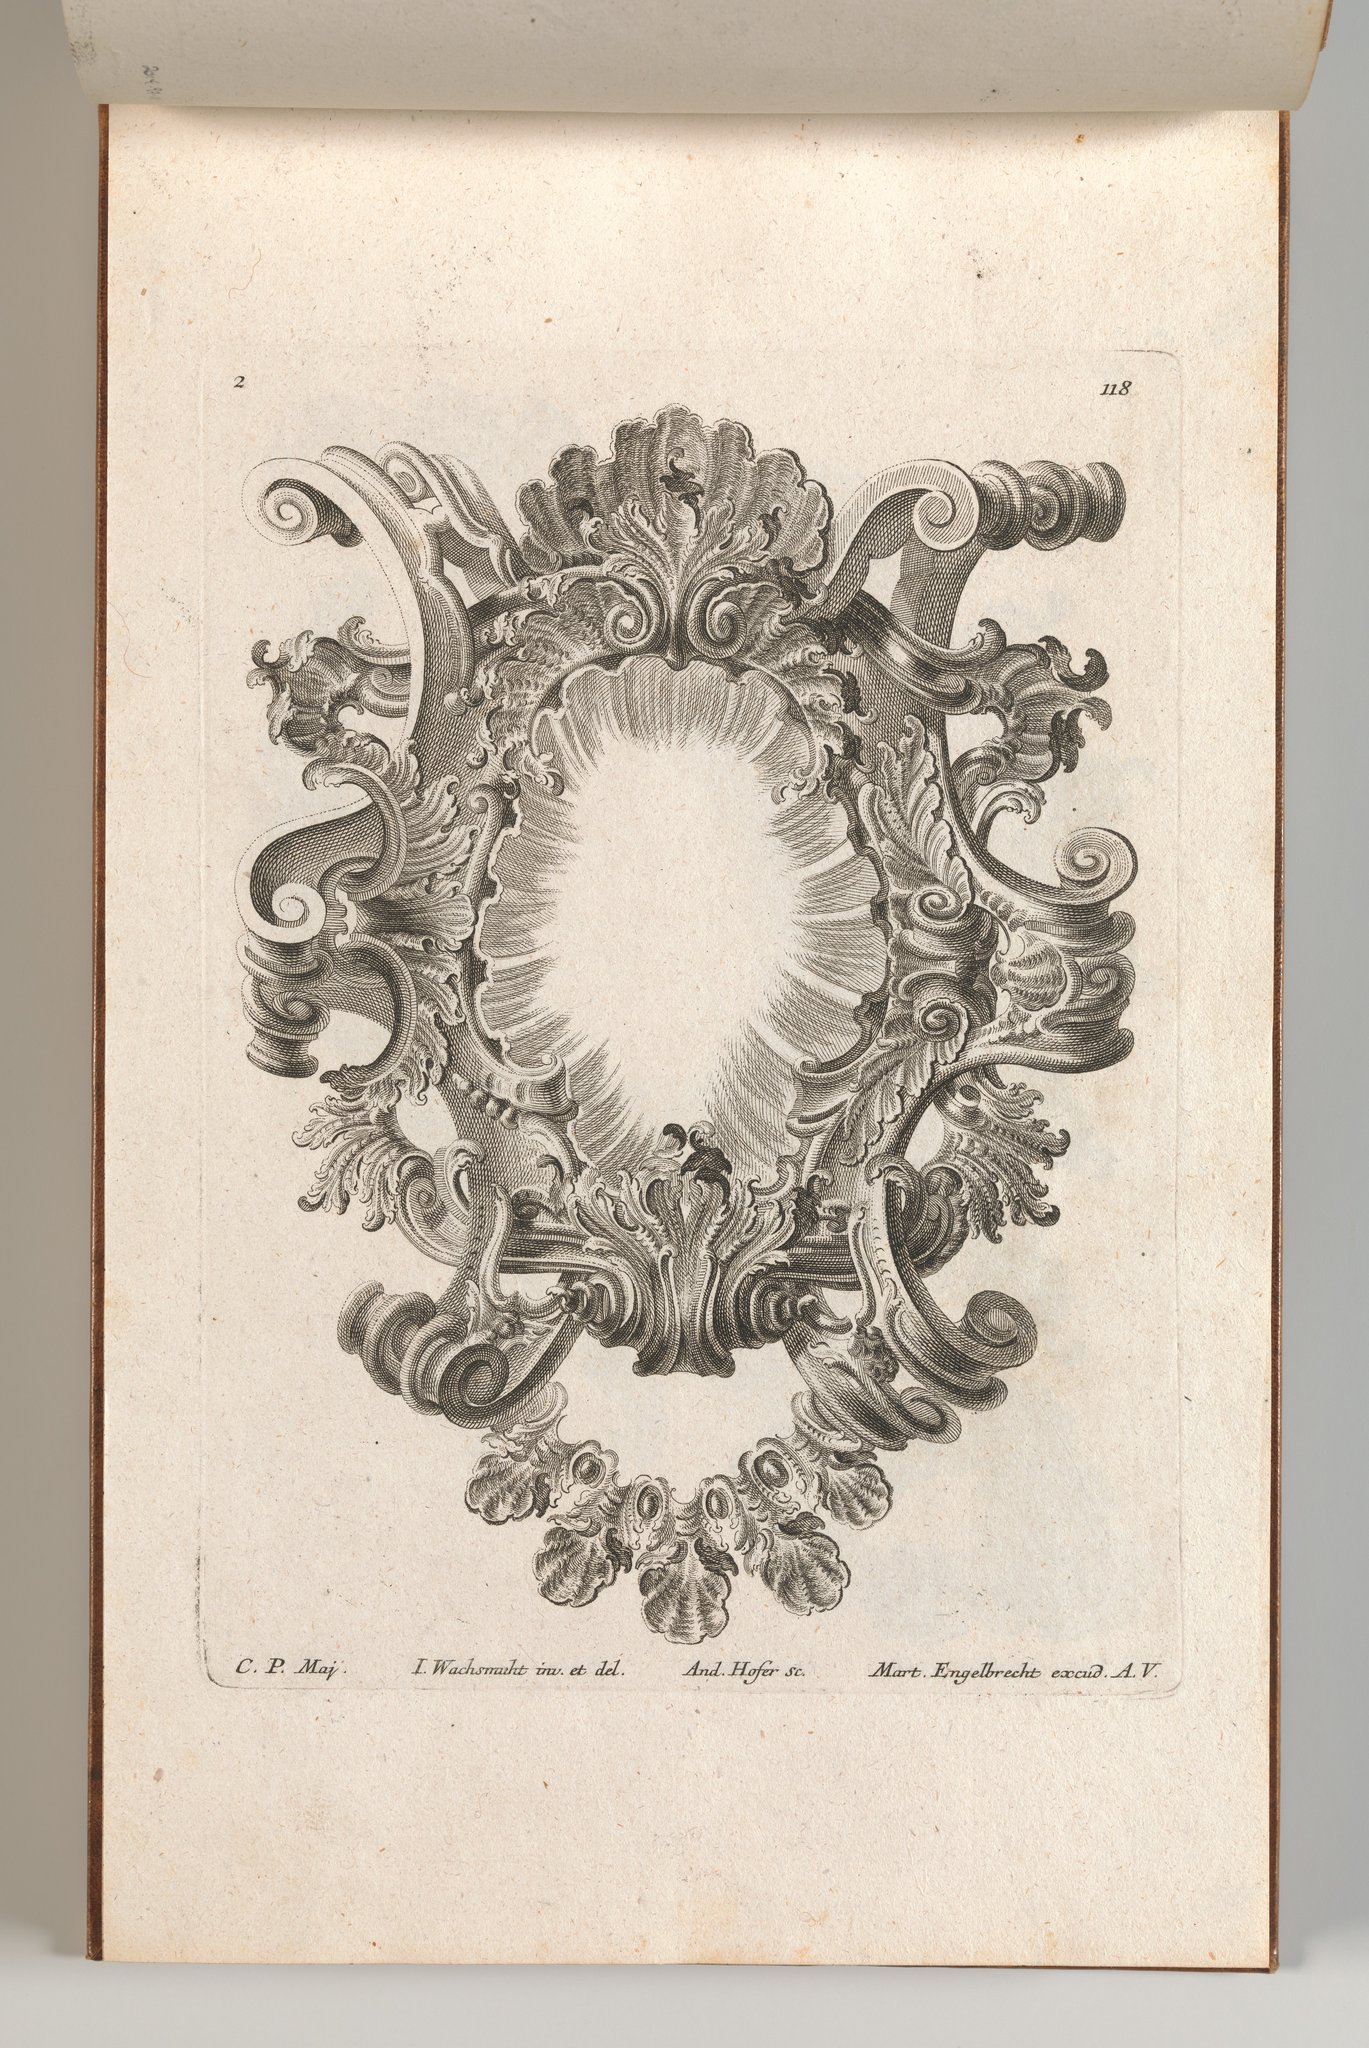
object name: album print ornament architecture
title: Design for a Cartouche, Plate 2 from 'Allerneueste Façon einiger Schild oder Cartouches'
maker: andreas hofer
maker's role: engraver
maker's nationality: central european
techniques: etching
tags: cartouches